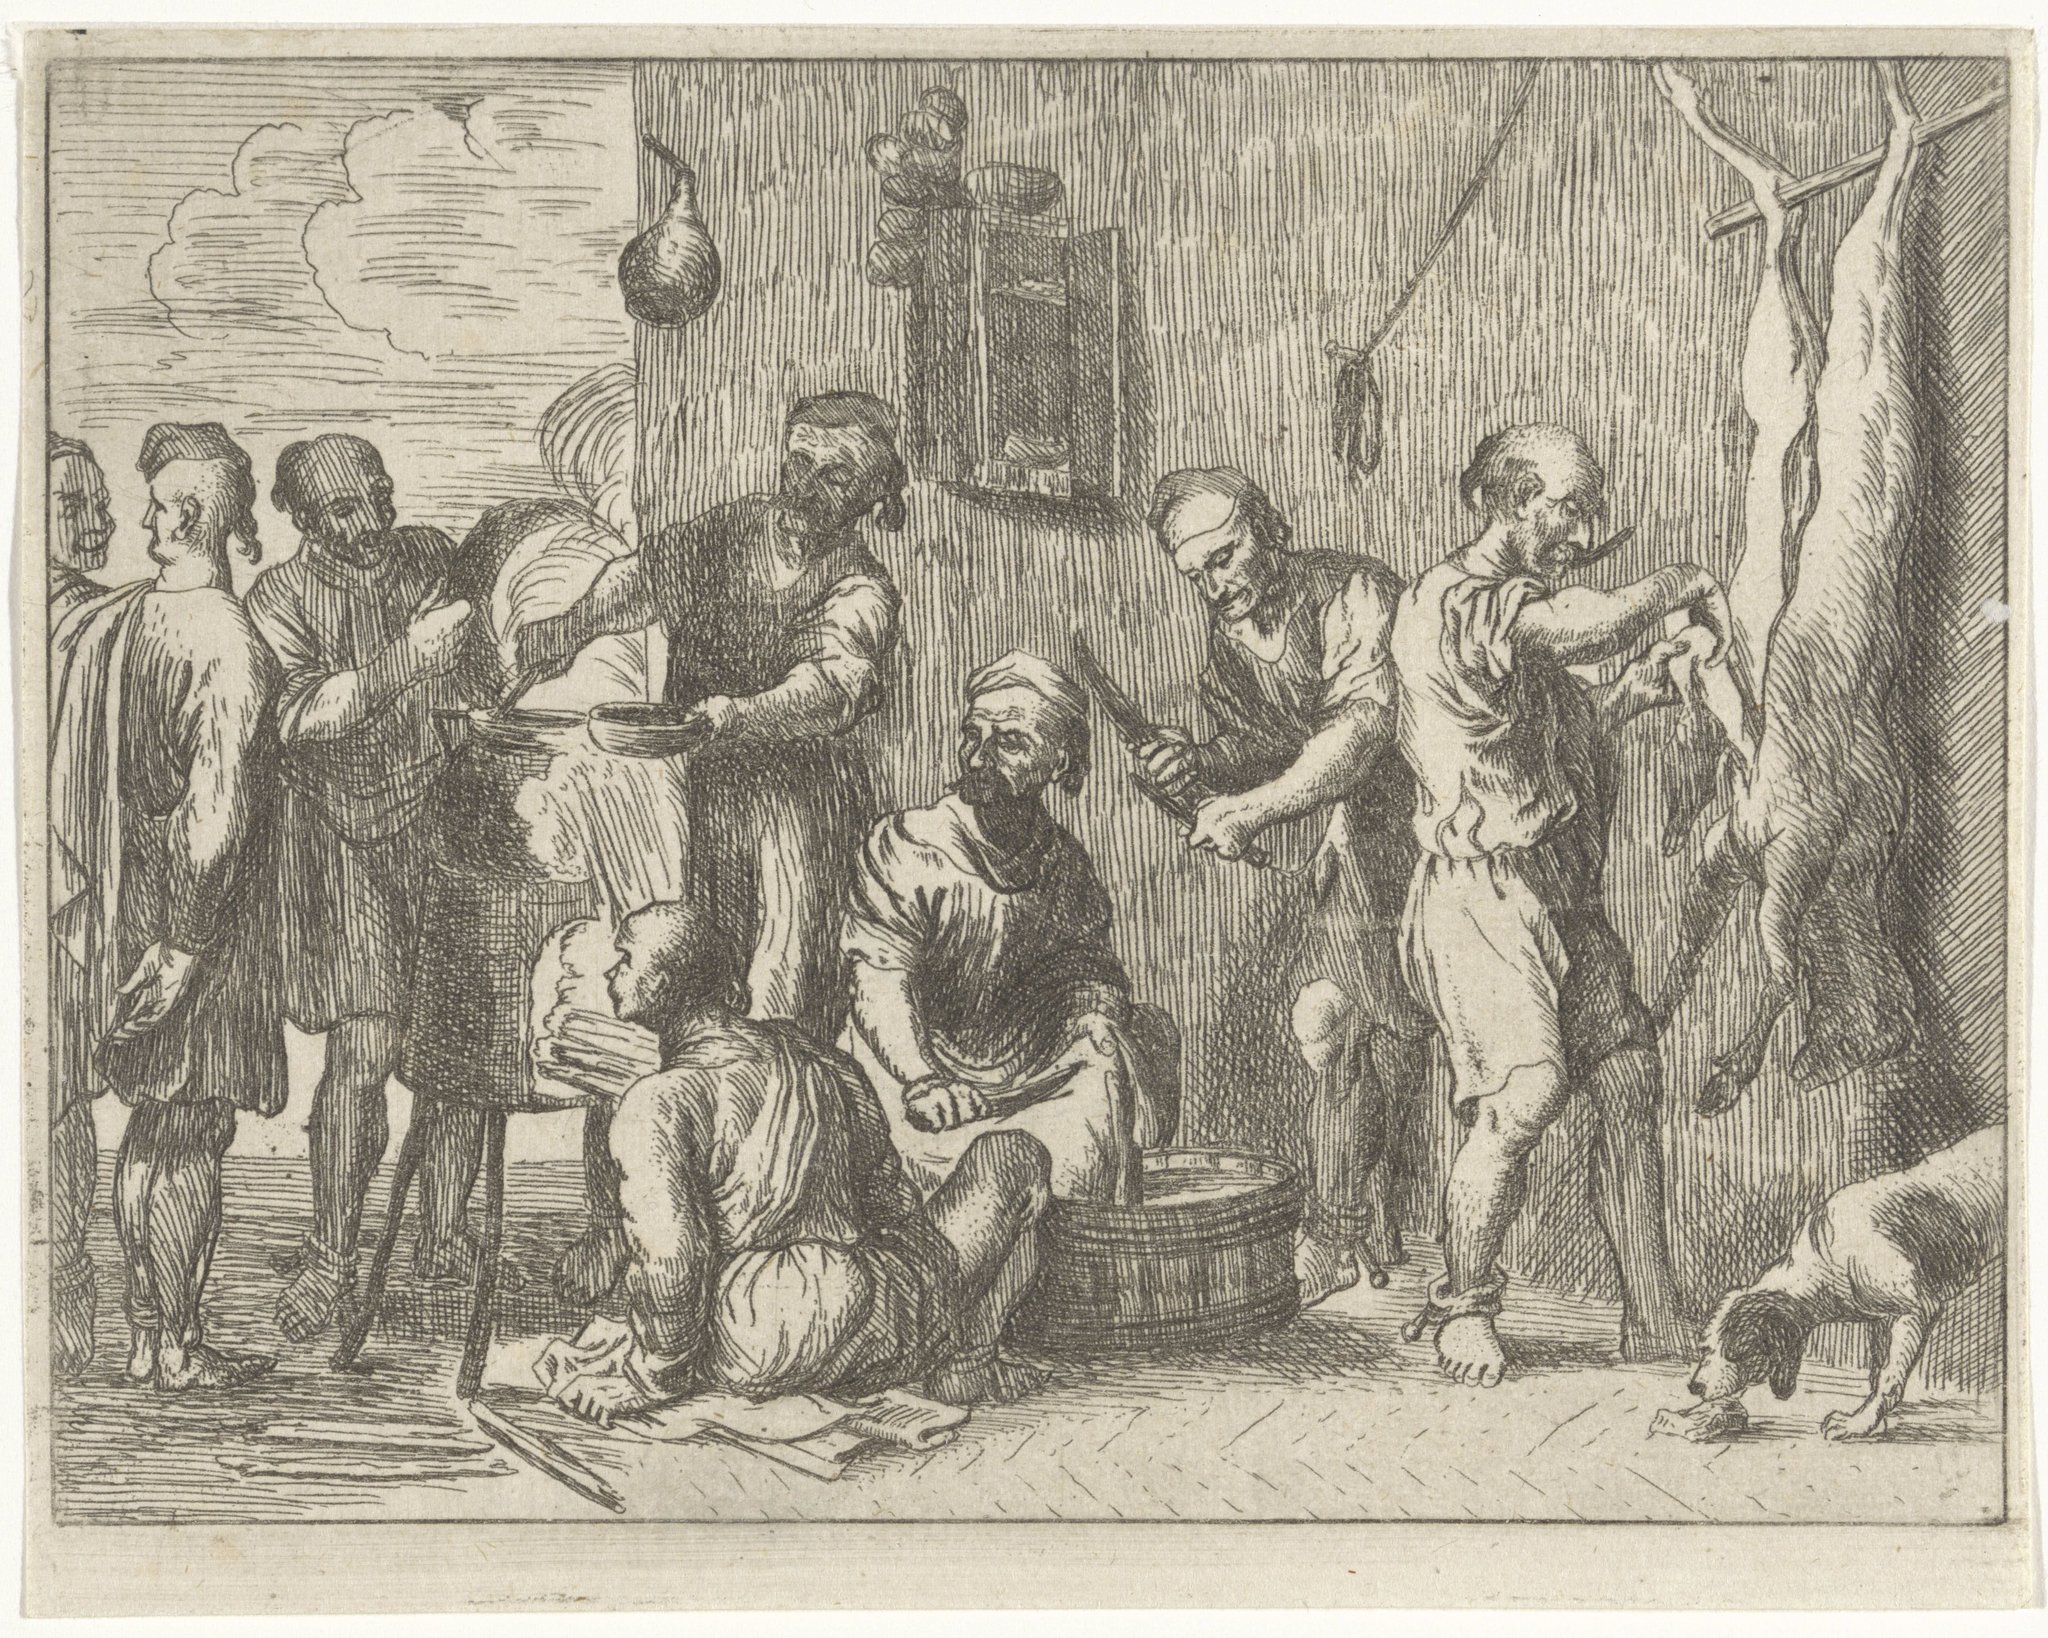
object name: print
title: Islamitische galeislaven krijgen soep terwijl een schaap wordt uitgebeend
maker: m. schaep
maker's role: print maker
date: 1649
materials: paper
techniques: etching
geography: northern netherlands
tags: harbour, kitchen-utensils: cauldron, wooden container: barrel, cask, bucket, slavery; serfs and enslaved persons, sheep, broth, soup, seaman: sailor, dog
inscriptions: collector's mark: Lugt 2228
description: Een kok deelt soep uit aan islamitische galeislaven, hij is zelf ook galeislaaf. In het midden zitten twee van hen bij een tobbe. Rechts wordt een schaap uitgebeend, een hond eet de resten op. Deze tot slaaf gemaakte mannen zijn als moslims te herkennen door het typerende kapsel (hoofd op een pluk na kaalgeschoren) dat zij verplicht waren te hebben.